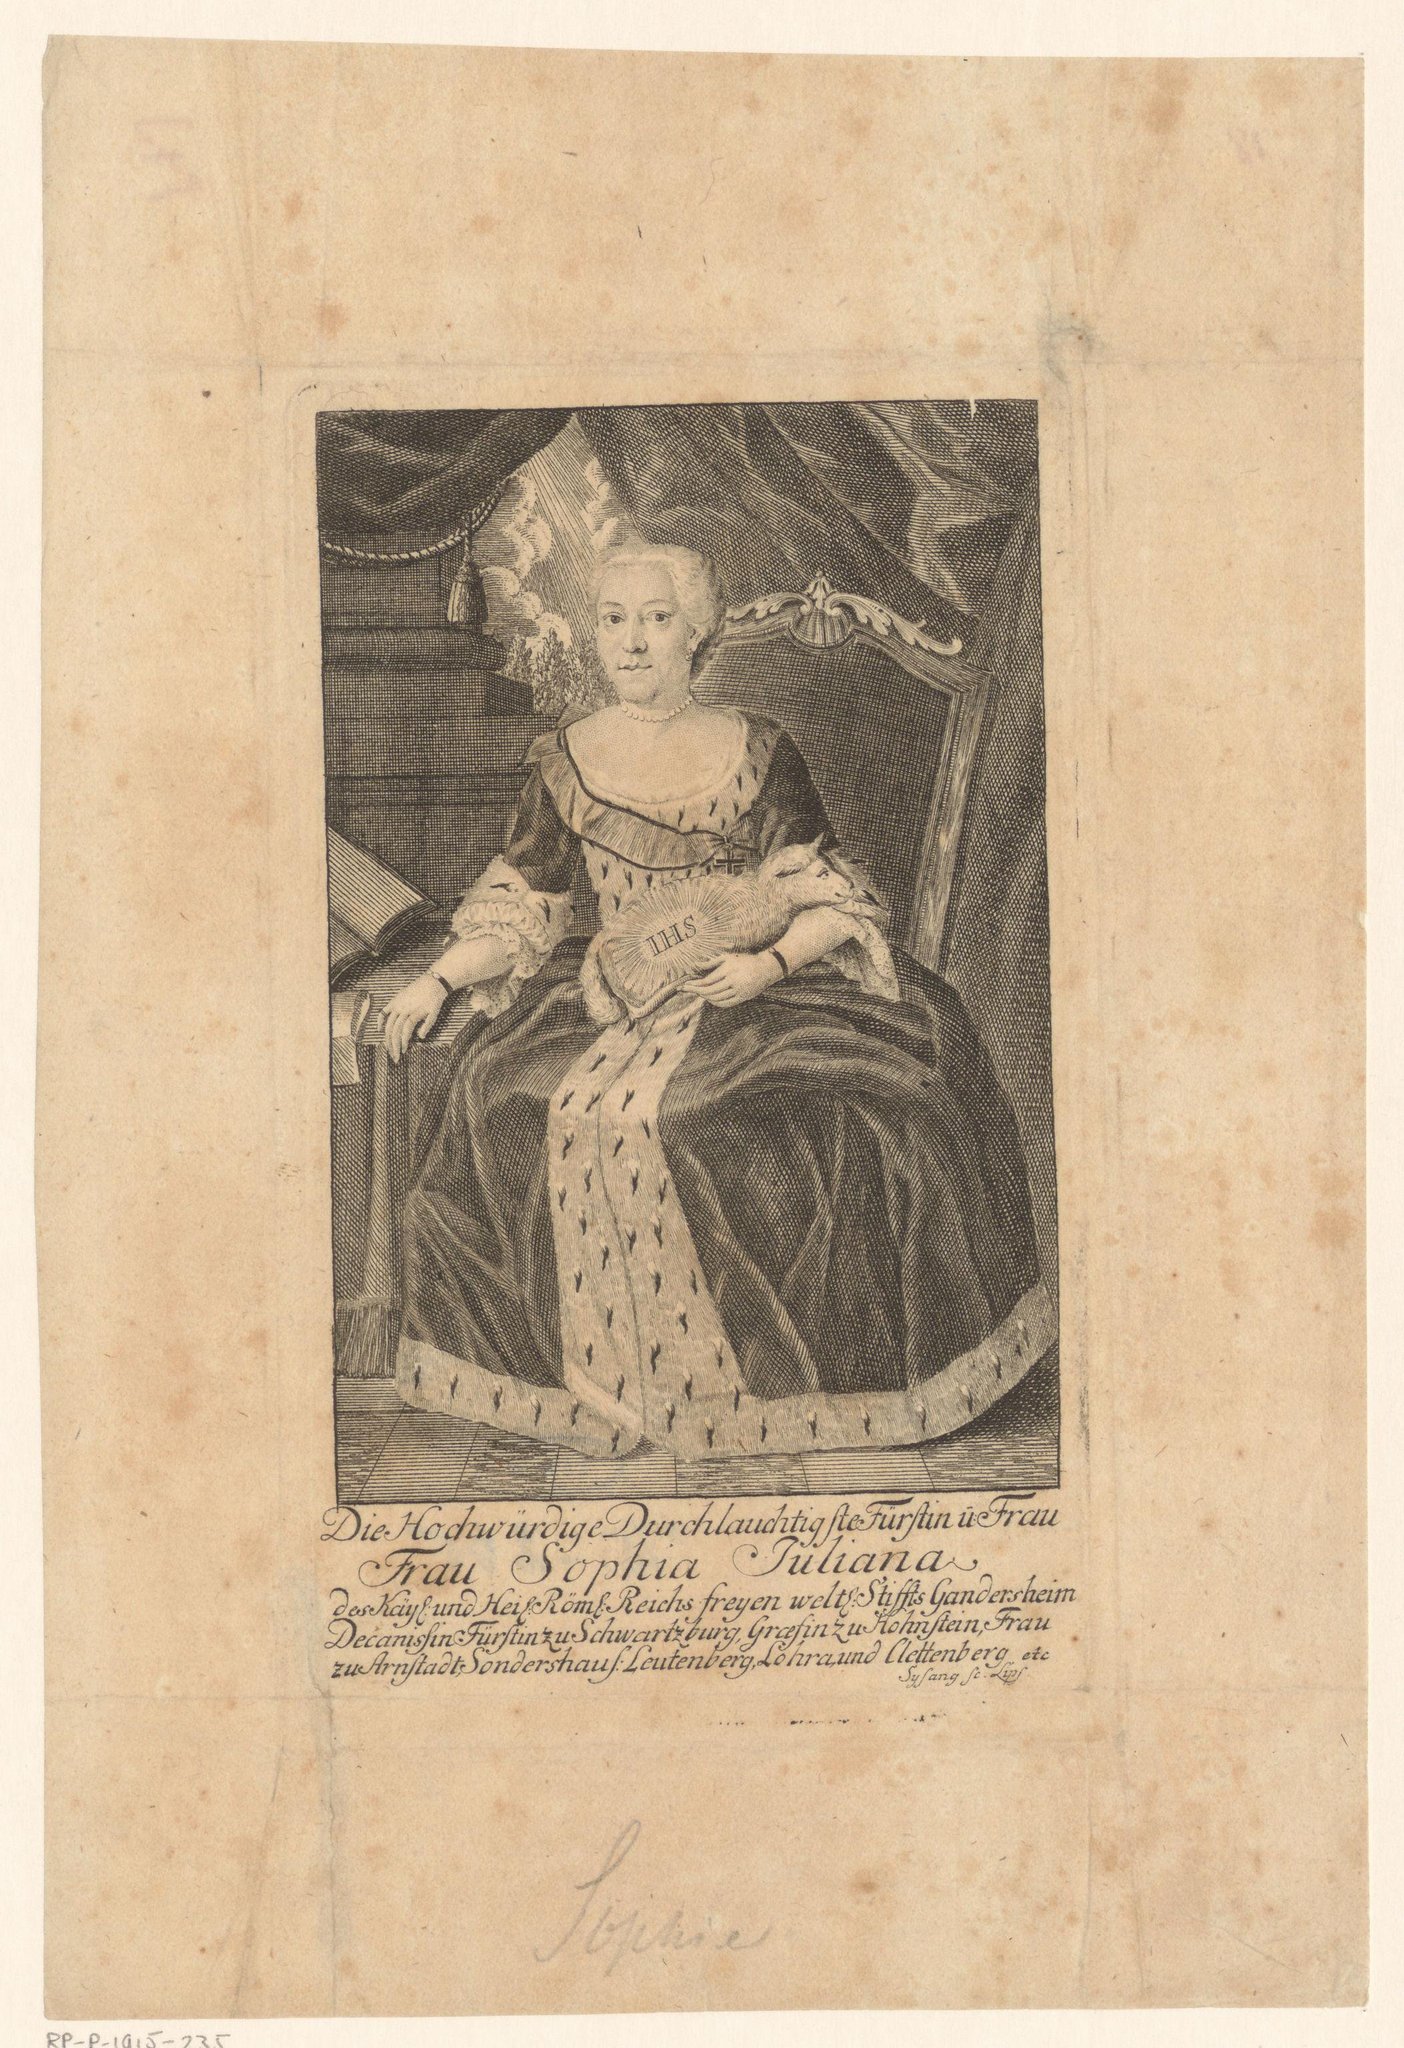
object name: print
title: Portret van Sofia Juliana Schwarzburg-Rudolstadt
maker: johann christoph sysang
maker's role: print maker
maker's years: 1703-1757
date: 1716-1757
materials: paper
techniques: engraving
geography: leipzig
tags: ihs ('iesus hominum salvator') ~ symbol of christ, historical persons - bb - woman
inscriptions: collector's mark: Lugt 2228